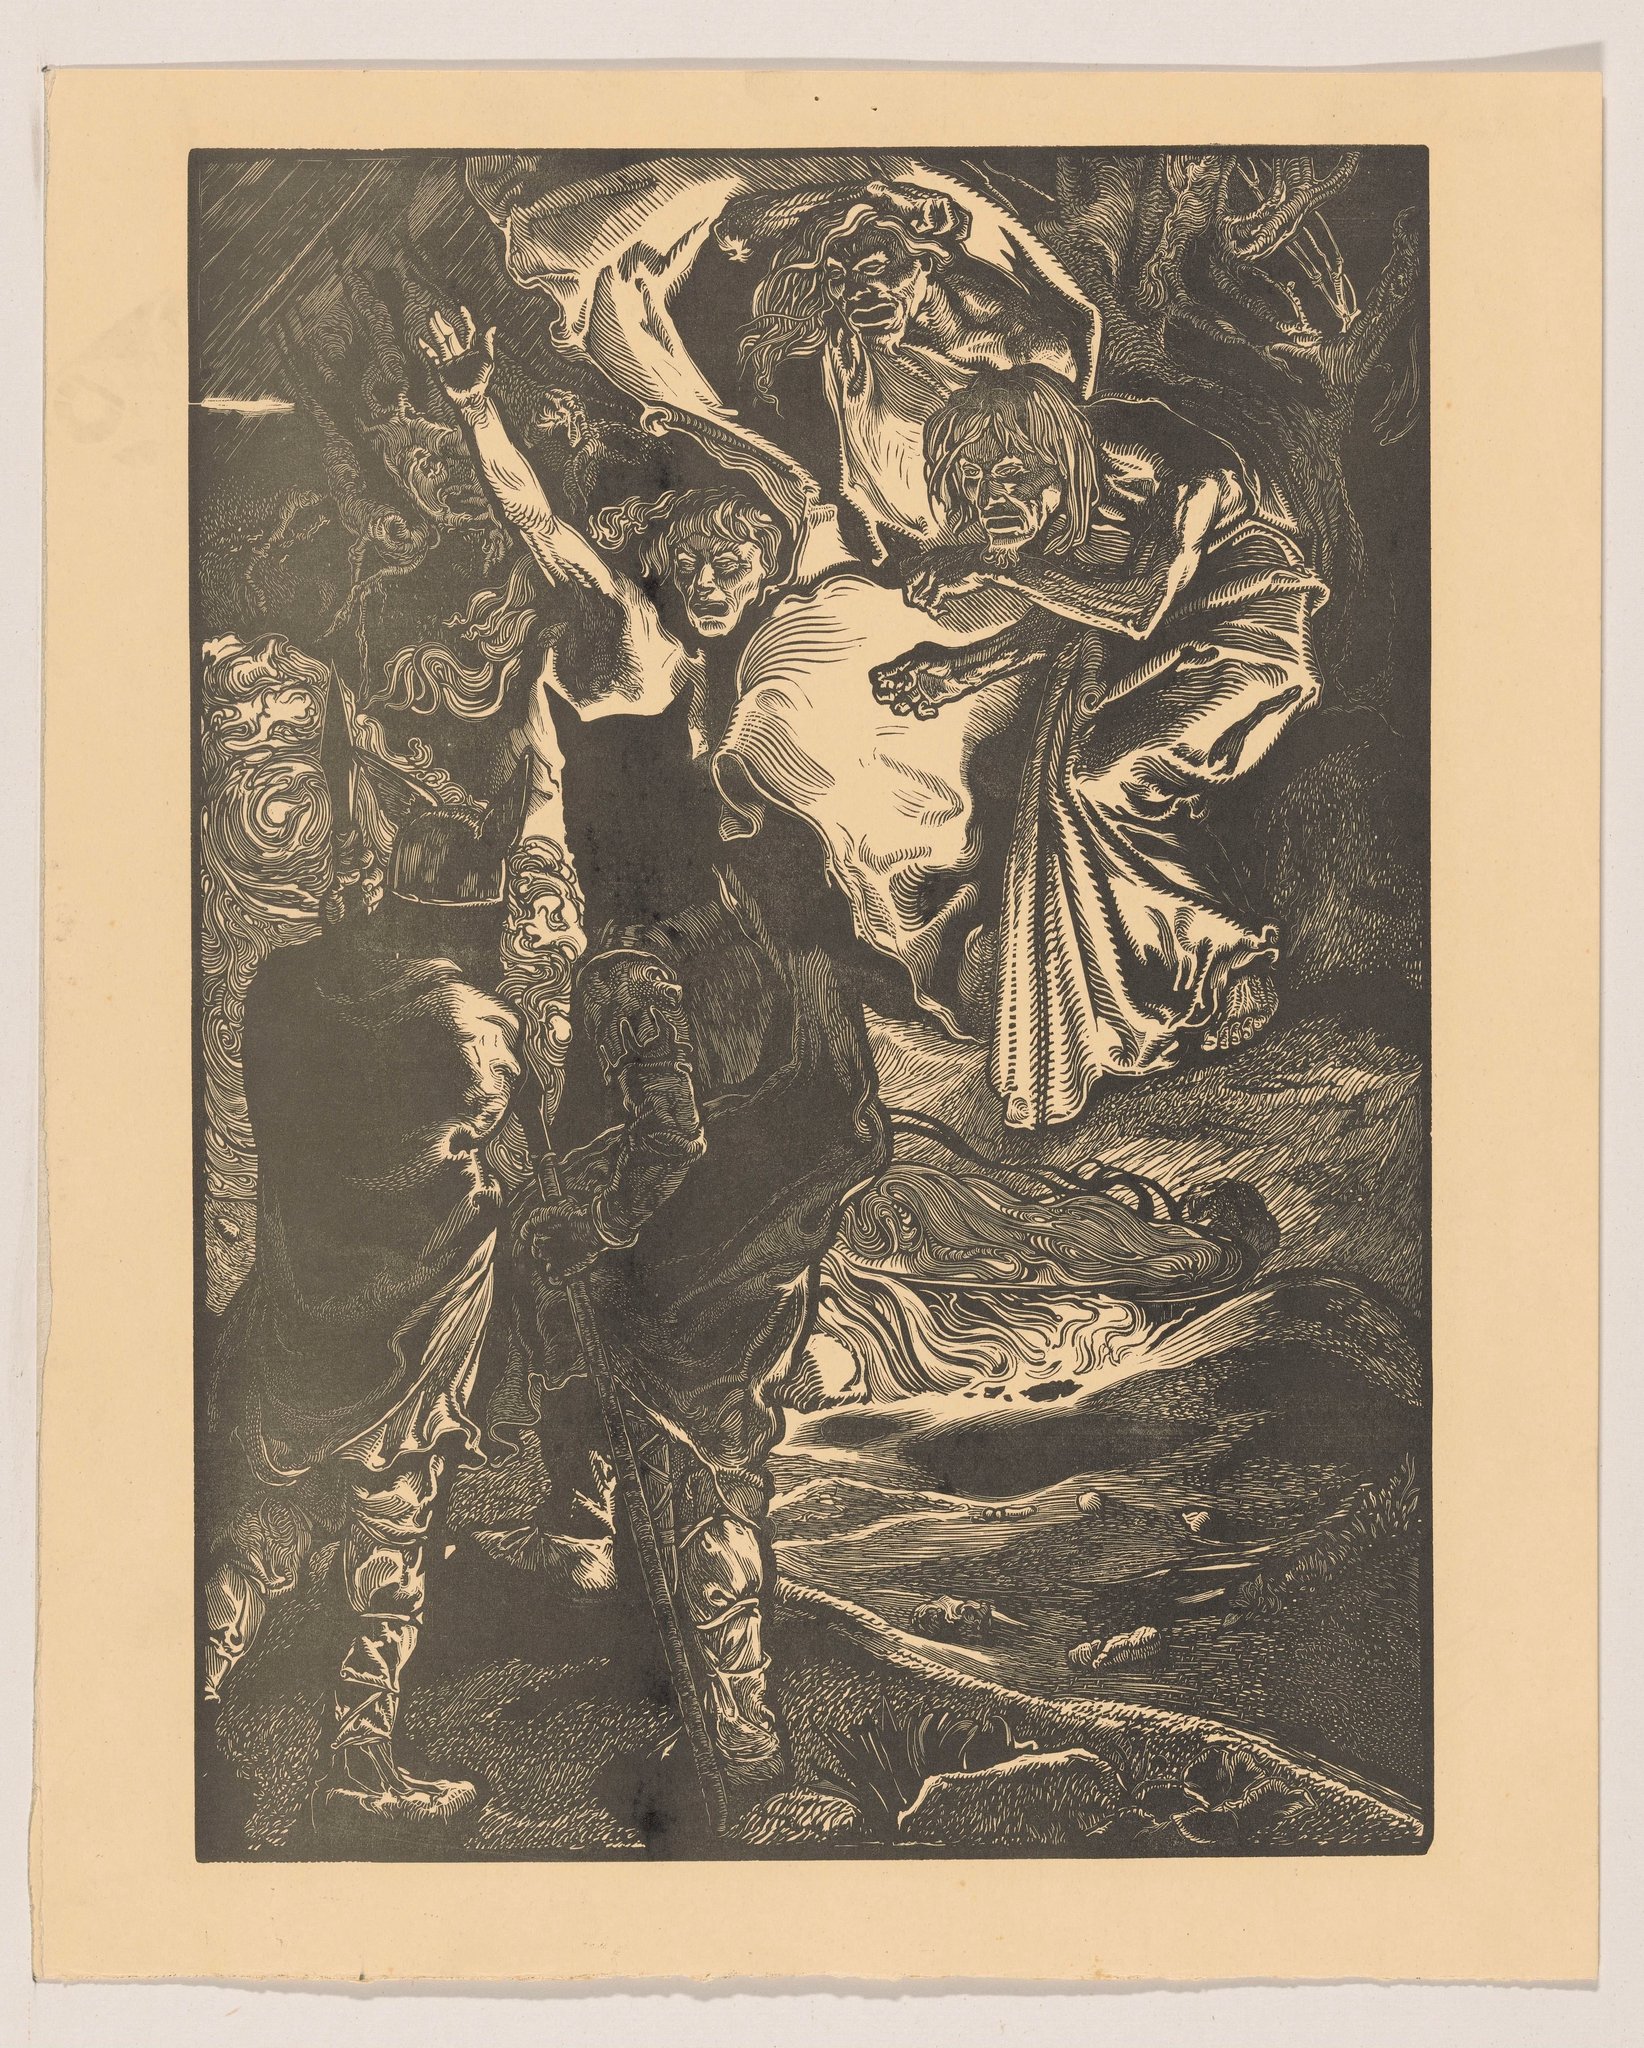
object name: print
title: Compositie met heksen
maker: johannes josephus aarts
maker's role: draughtsman, print maker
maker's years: 1871-1934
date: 1881-1934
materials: paper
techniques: woodcut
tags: groups of witches, macbeth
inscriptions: collector's mark: Lugt 2166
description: Linksonder Macbeth en zijn vriend Banquo, rechtsboven de drie heksen die voor elk van hen voorspellingen in petto hebben.